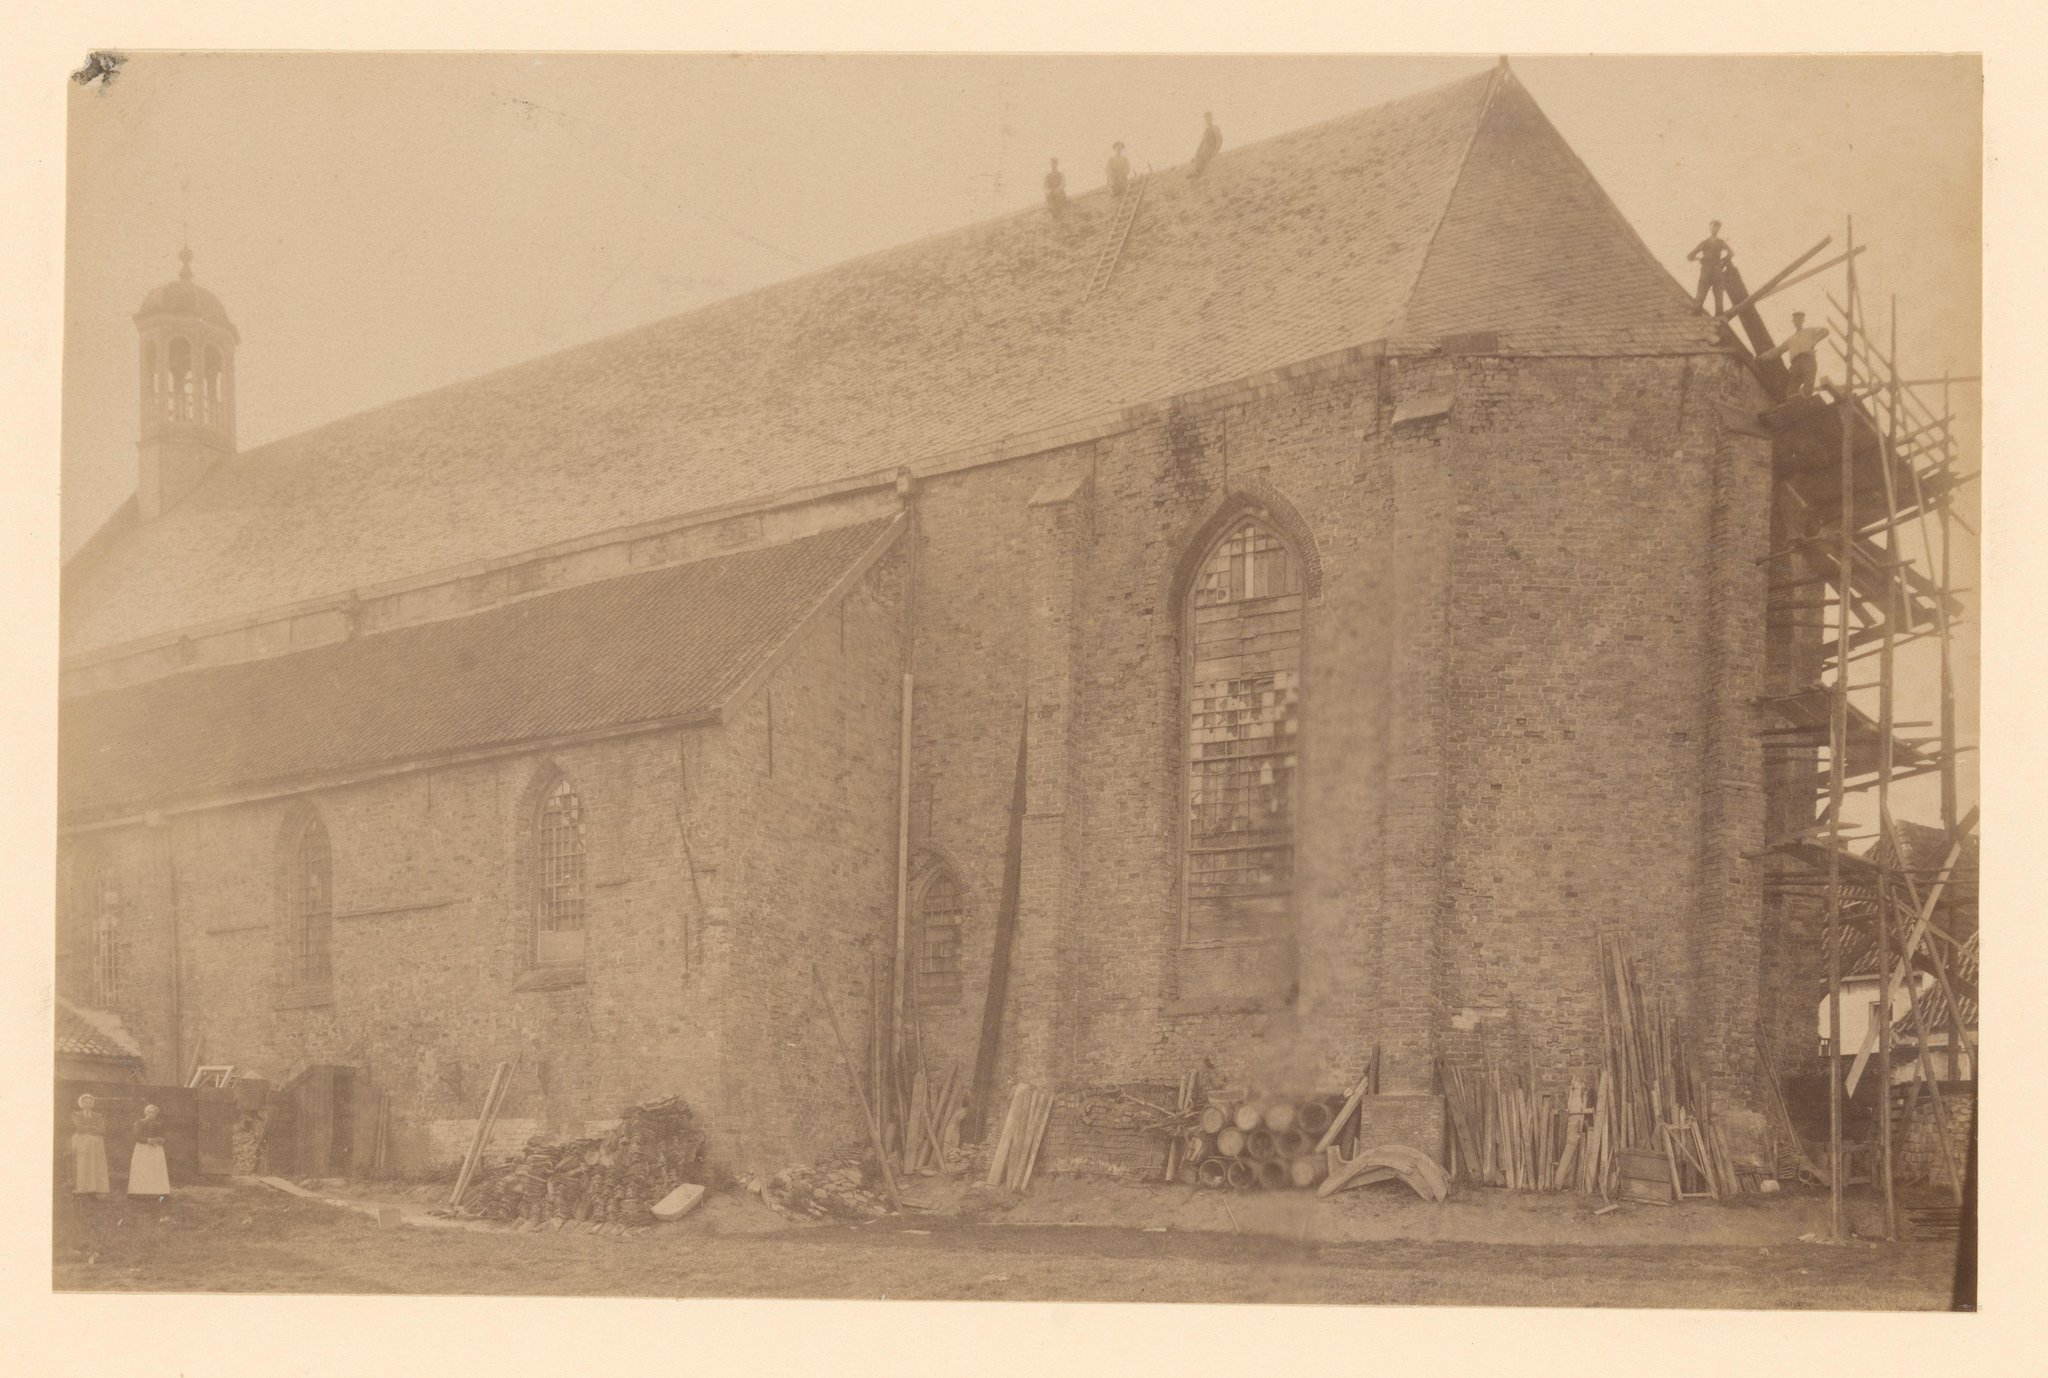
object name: photograph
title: Broerekerk te Bolsward, tijdens herstel- of restauratiewerkzaamheden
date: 1903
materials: cardboard, photographic support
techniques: albumen print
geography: bolsward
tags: church (exterior)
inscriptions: annotation: ‘Bolsward (Fr) / Broerenkerk / Juli 1903’, annotation: ‘Bolsward’